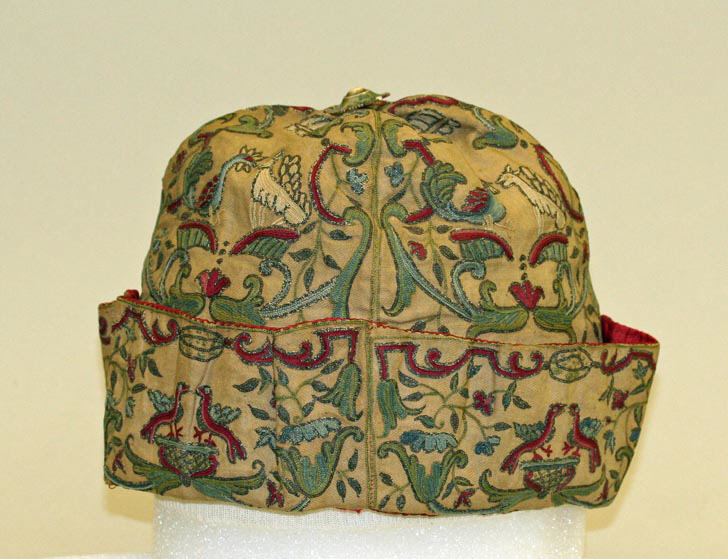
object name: cap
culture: european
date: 1601-1800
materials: linen, silk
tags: birds